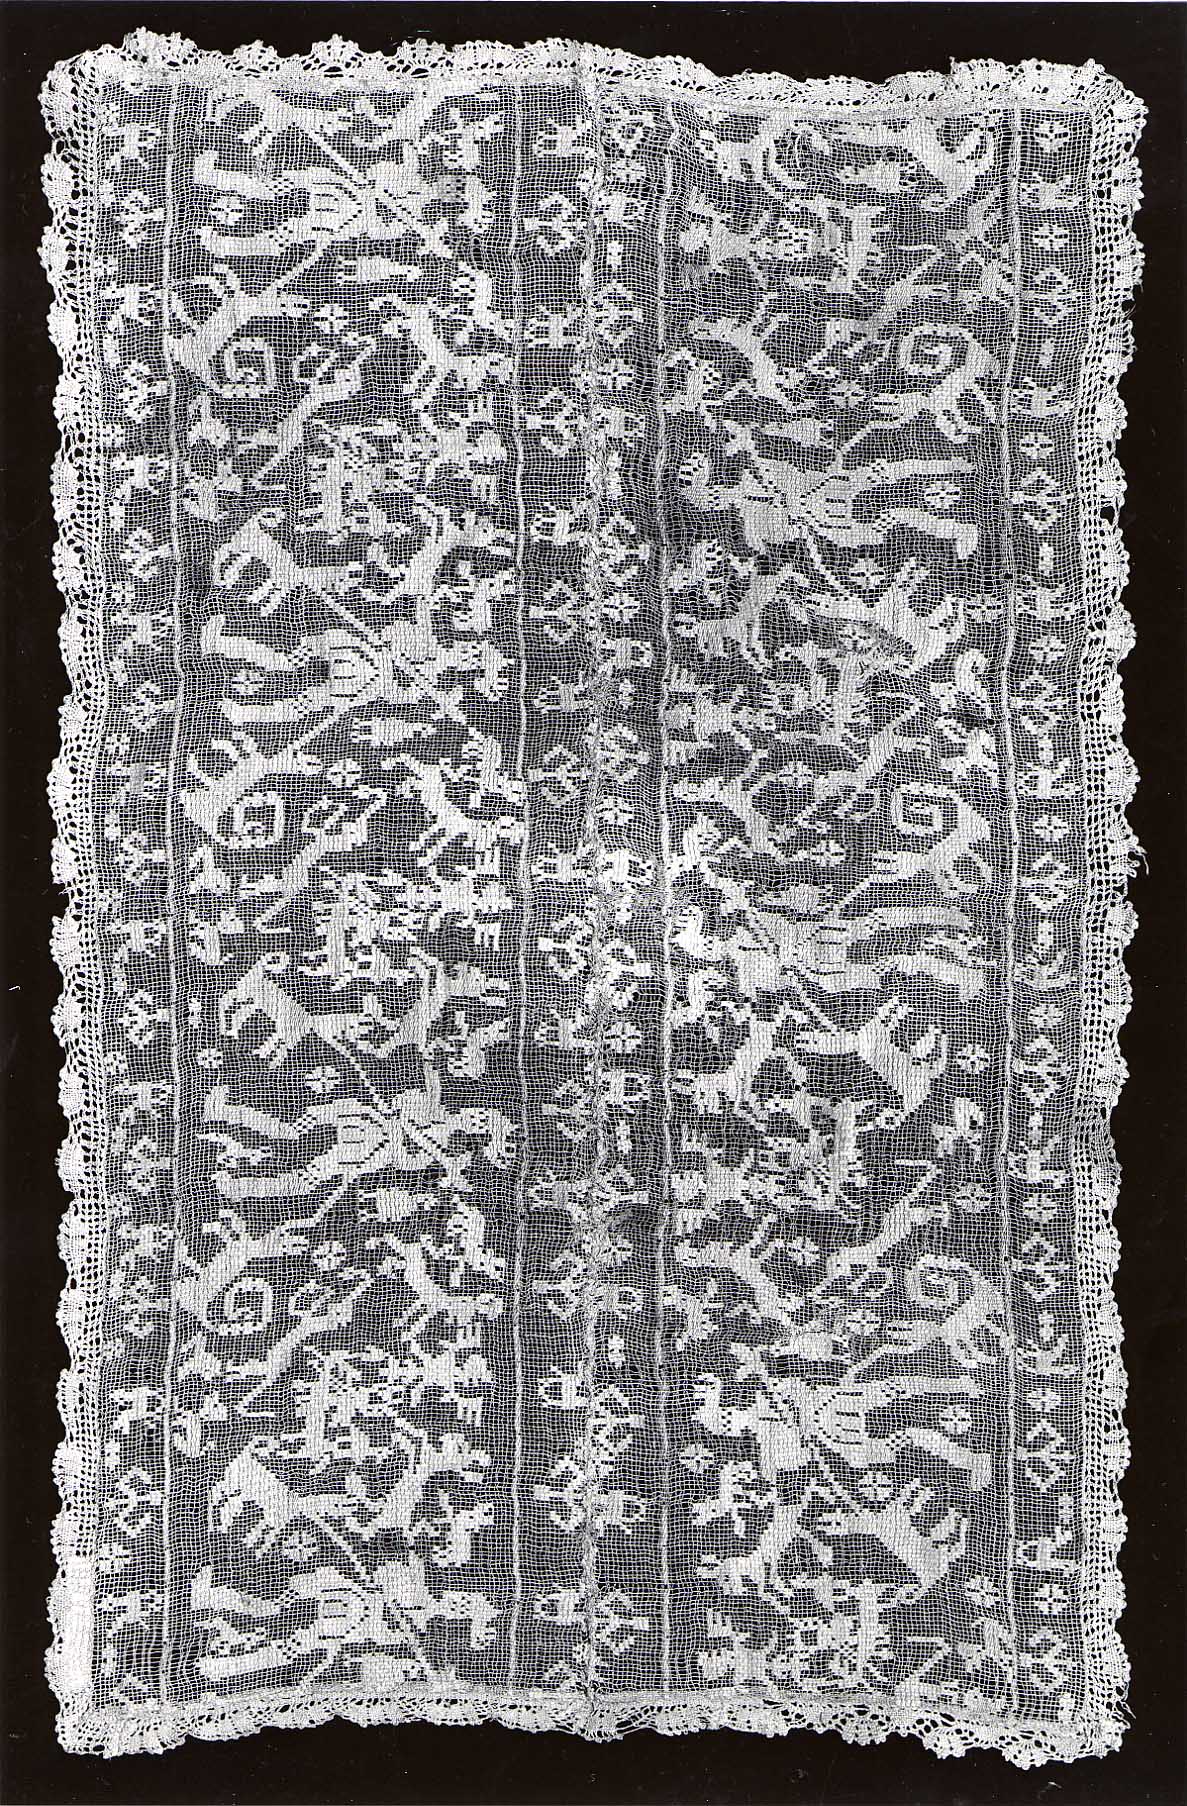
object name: textile cover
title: Cover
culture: german or italian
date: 1601-1633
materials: linen, silk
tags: human figures,animals